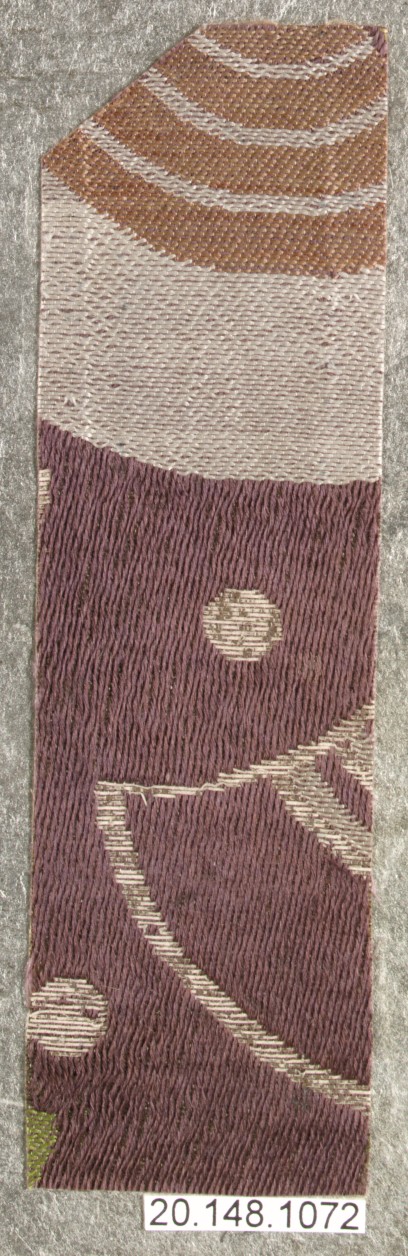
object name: piece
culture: japanese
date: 1701-1800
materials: silk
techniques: compound weave